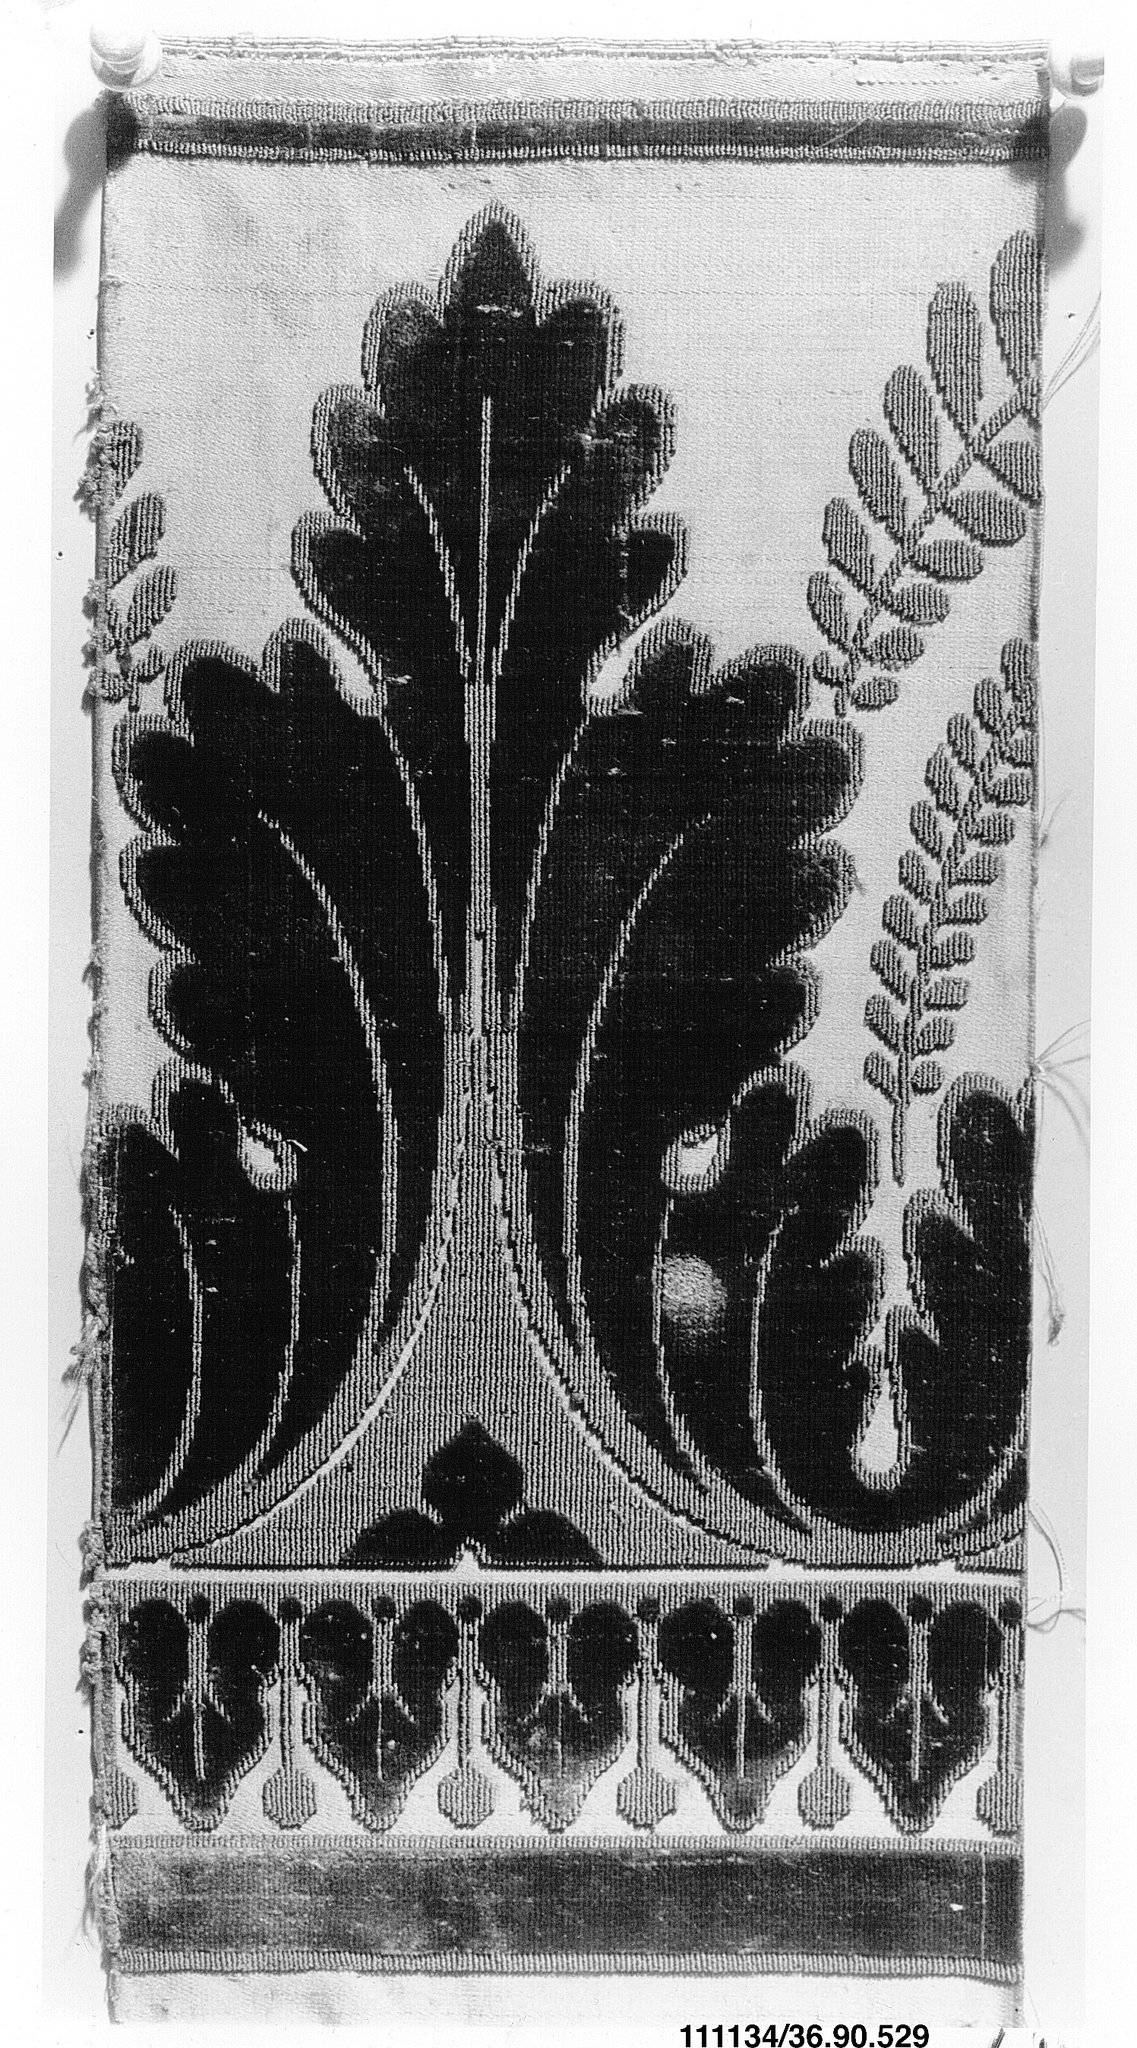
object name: piece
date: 1801-1833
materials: silk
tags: leaves